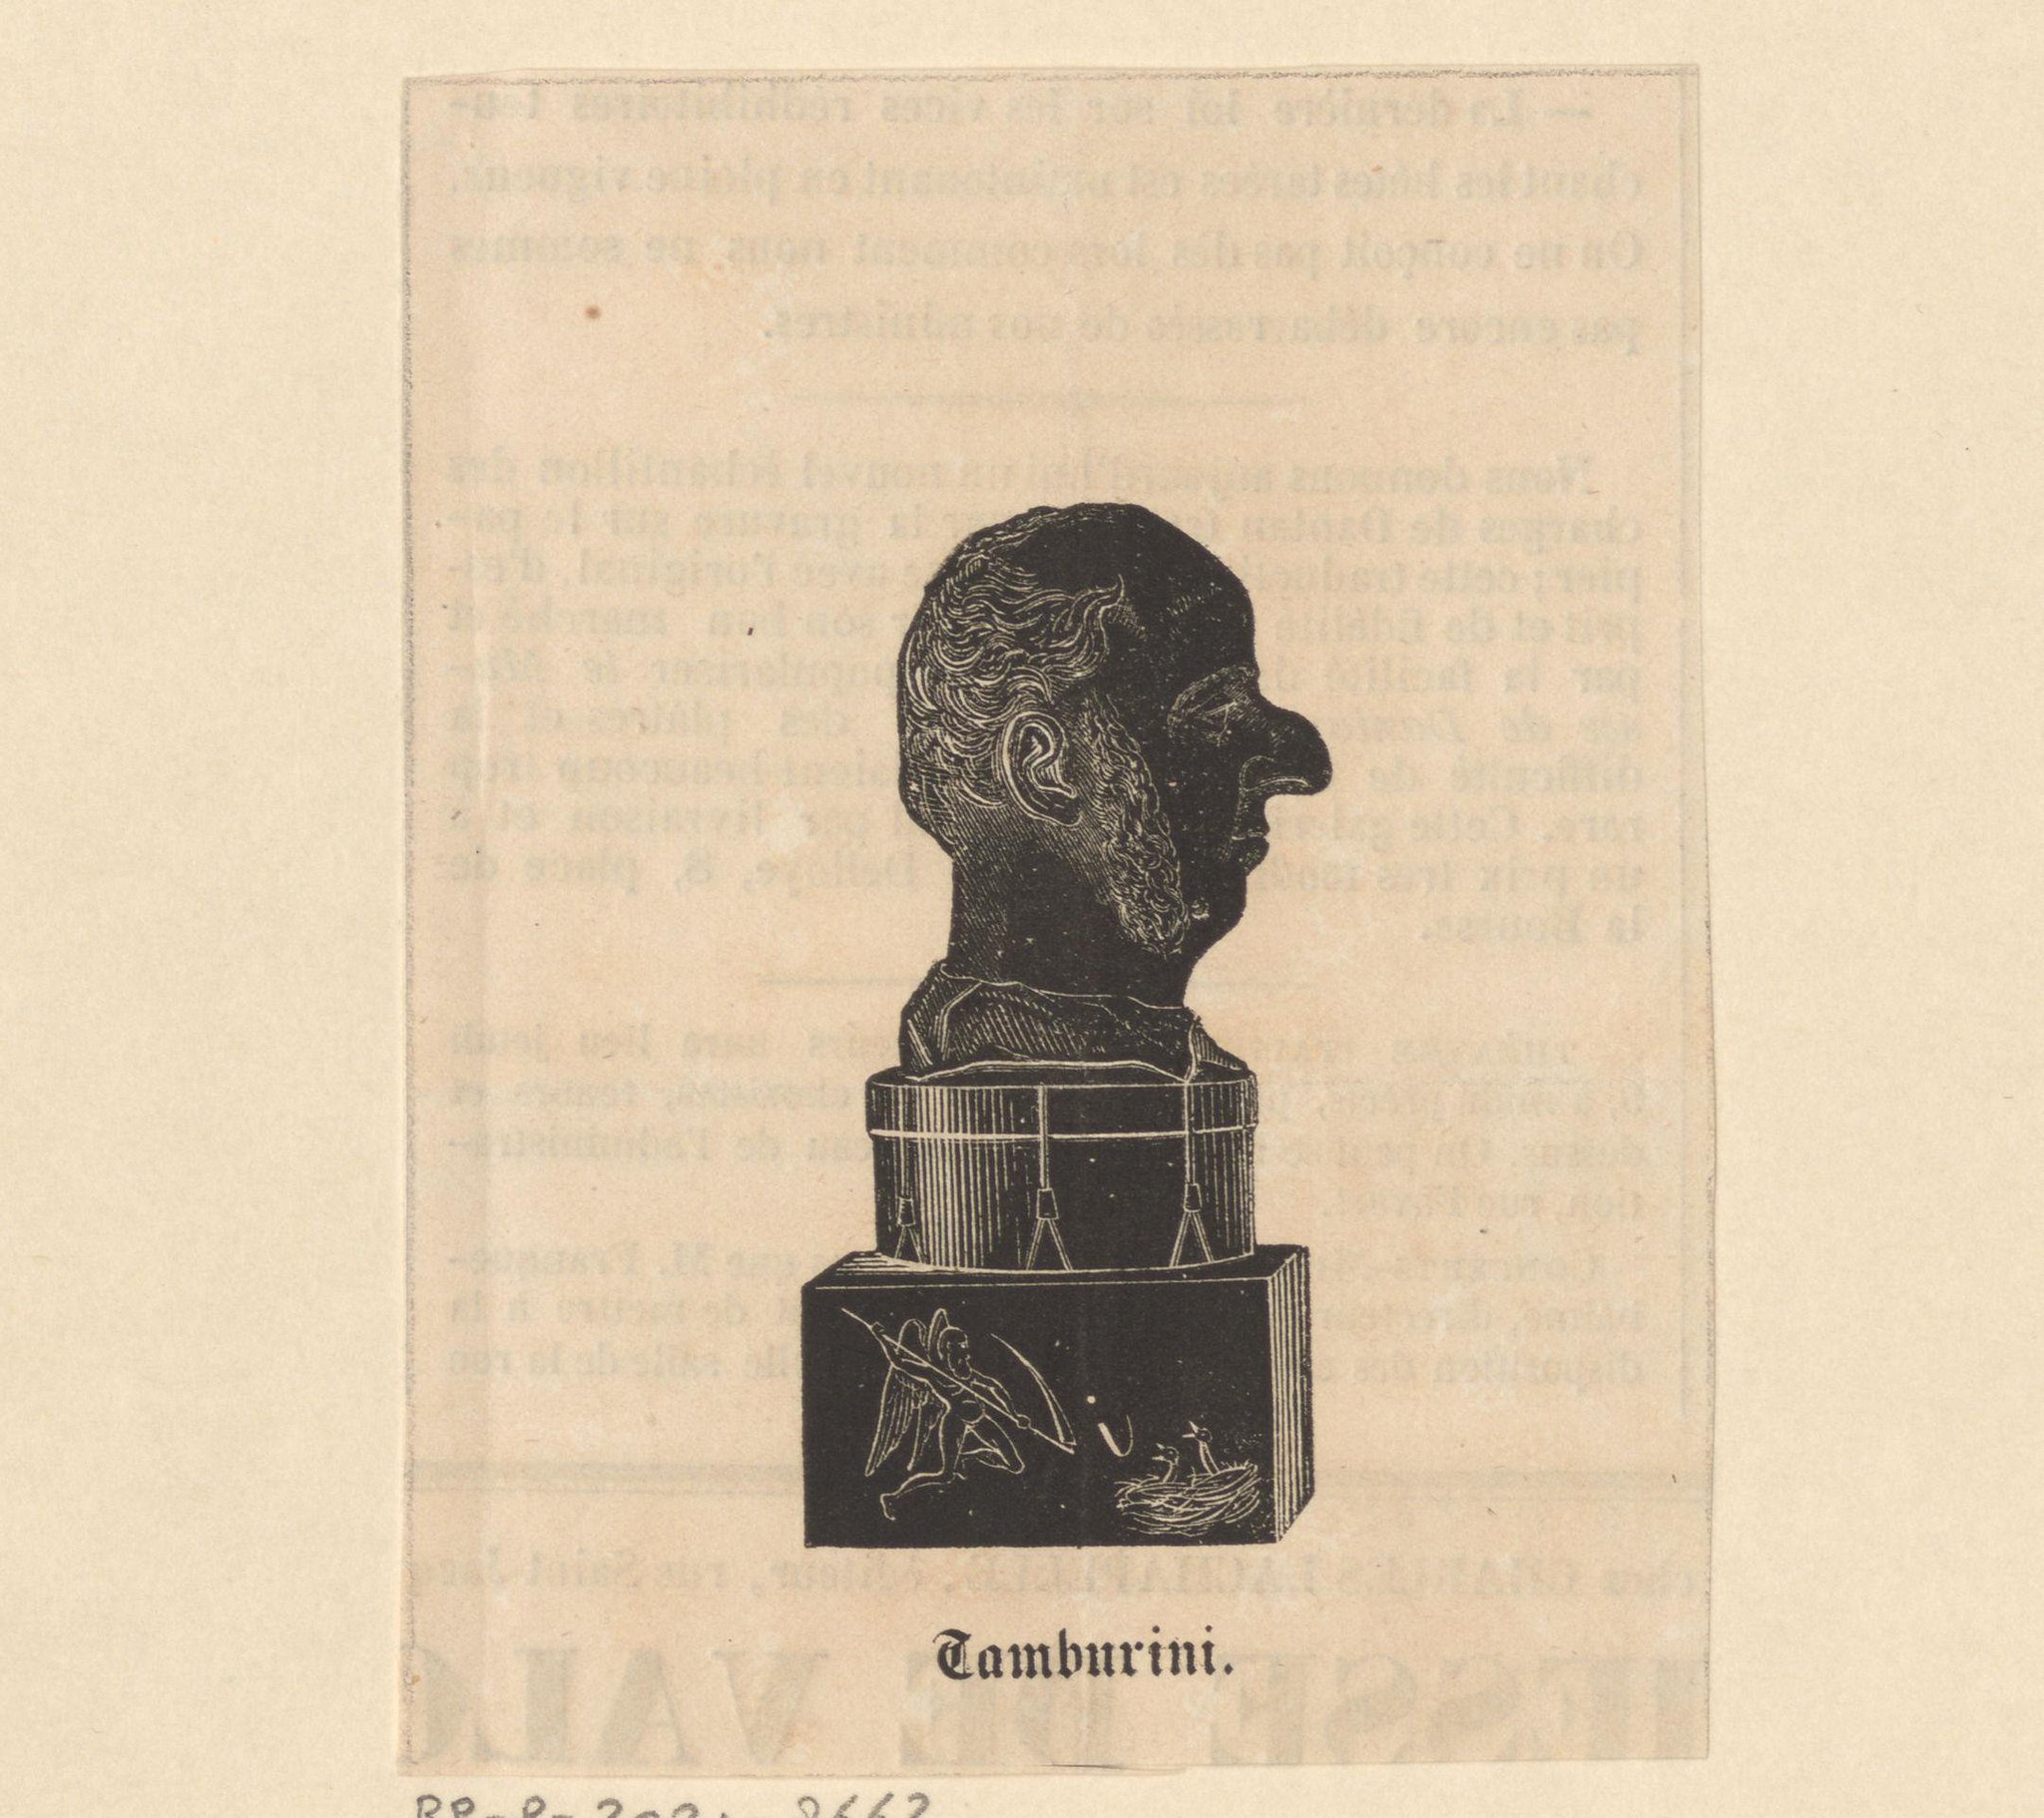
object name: cartoon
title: Karikatuur van Antonio Tamburini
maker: Anonymous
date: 1835-1850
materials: paper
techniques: letterpress printing, engraving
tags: caricatures (human types), historical persons, opera-singer (male)